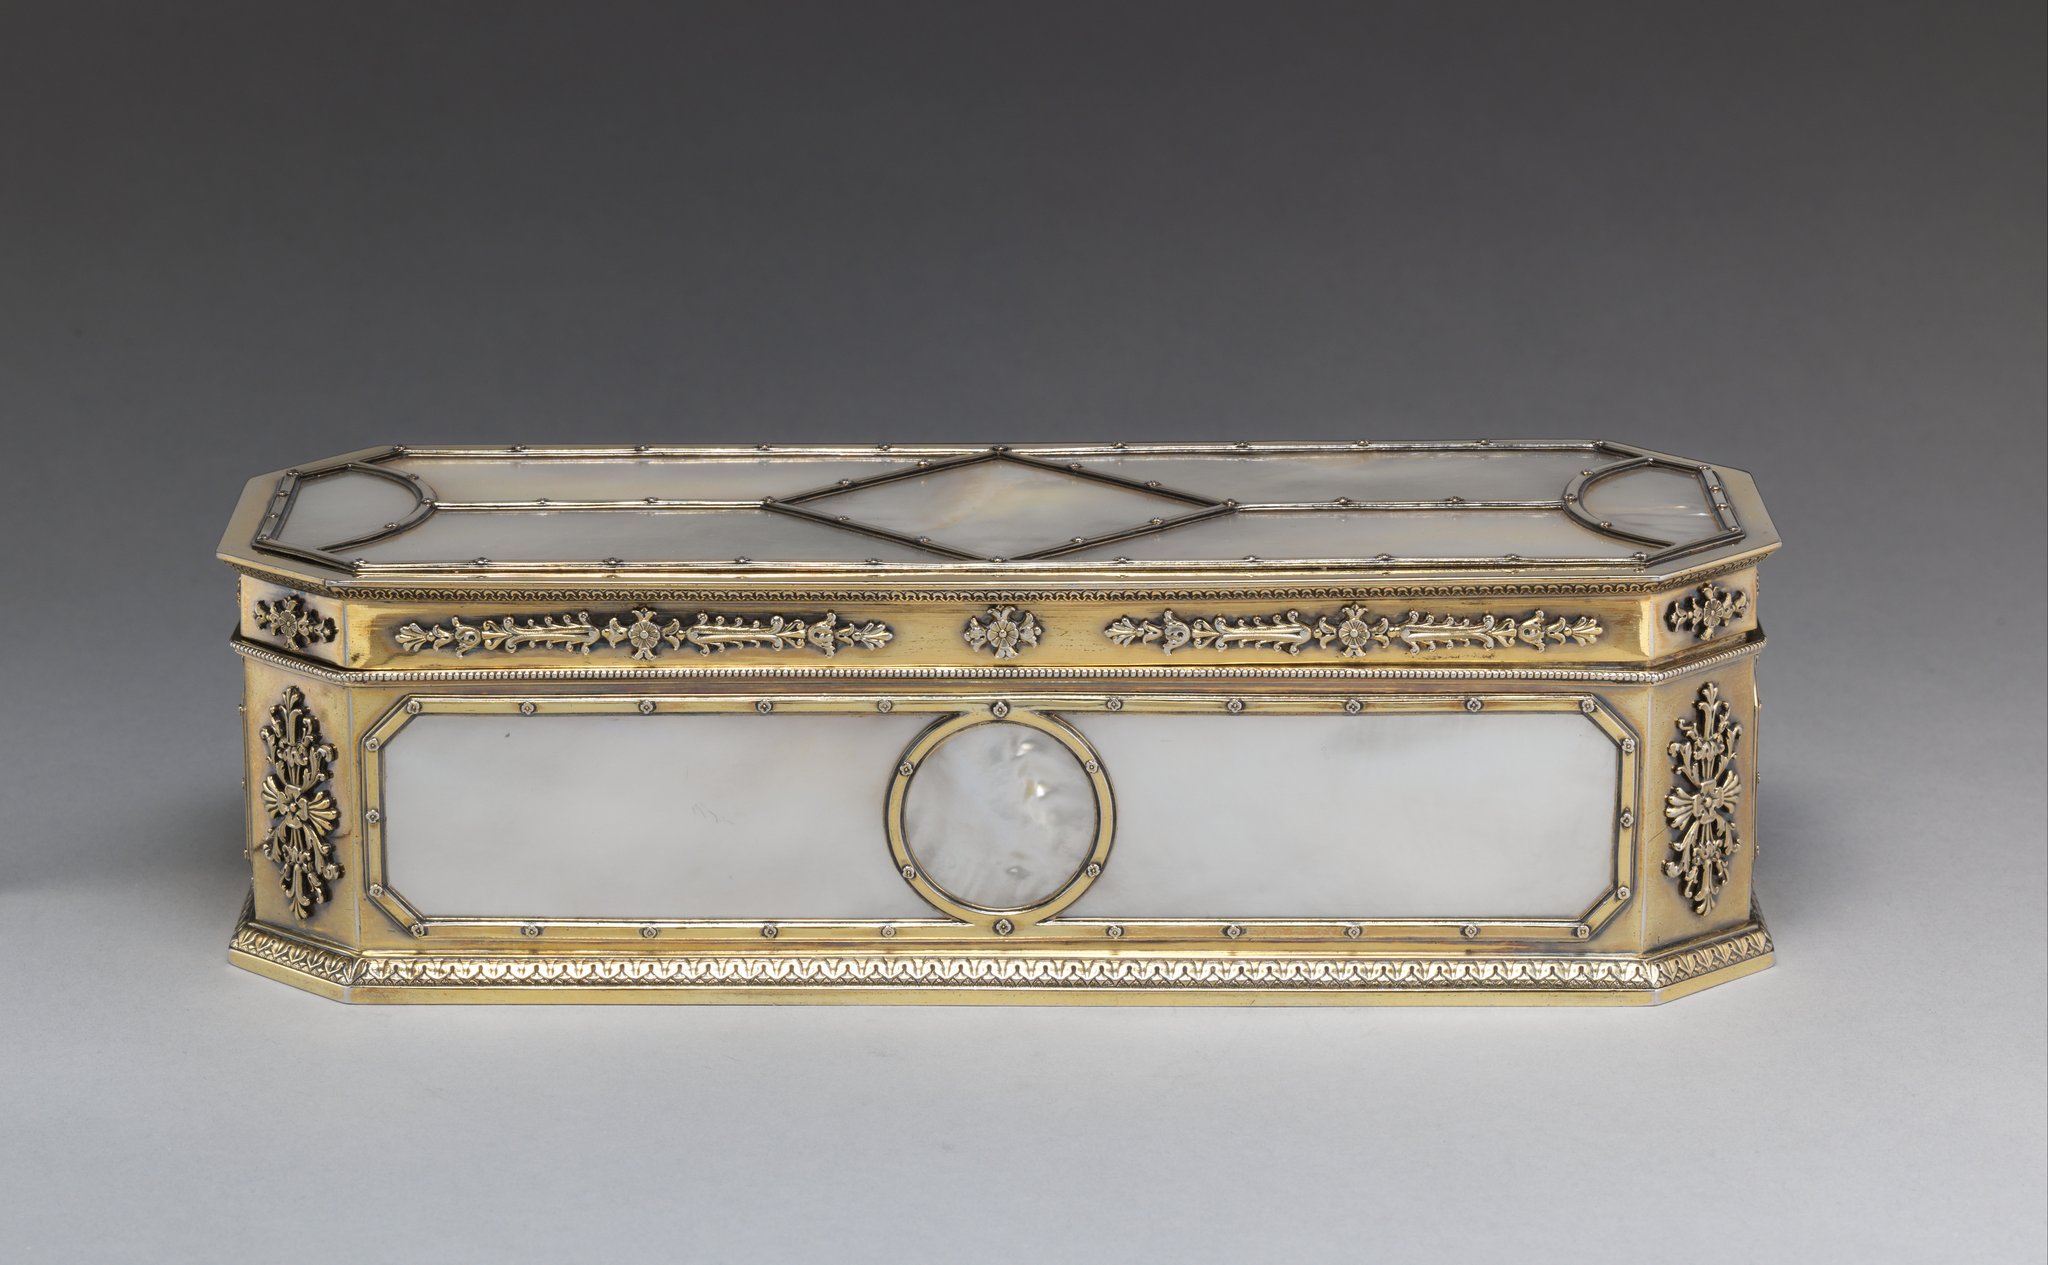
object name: box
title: Rectangular box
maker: andré aucoc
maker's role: maker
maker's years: 1825-1925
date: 1887-1911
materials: mother of pearl, silver gilt